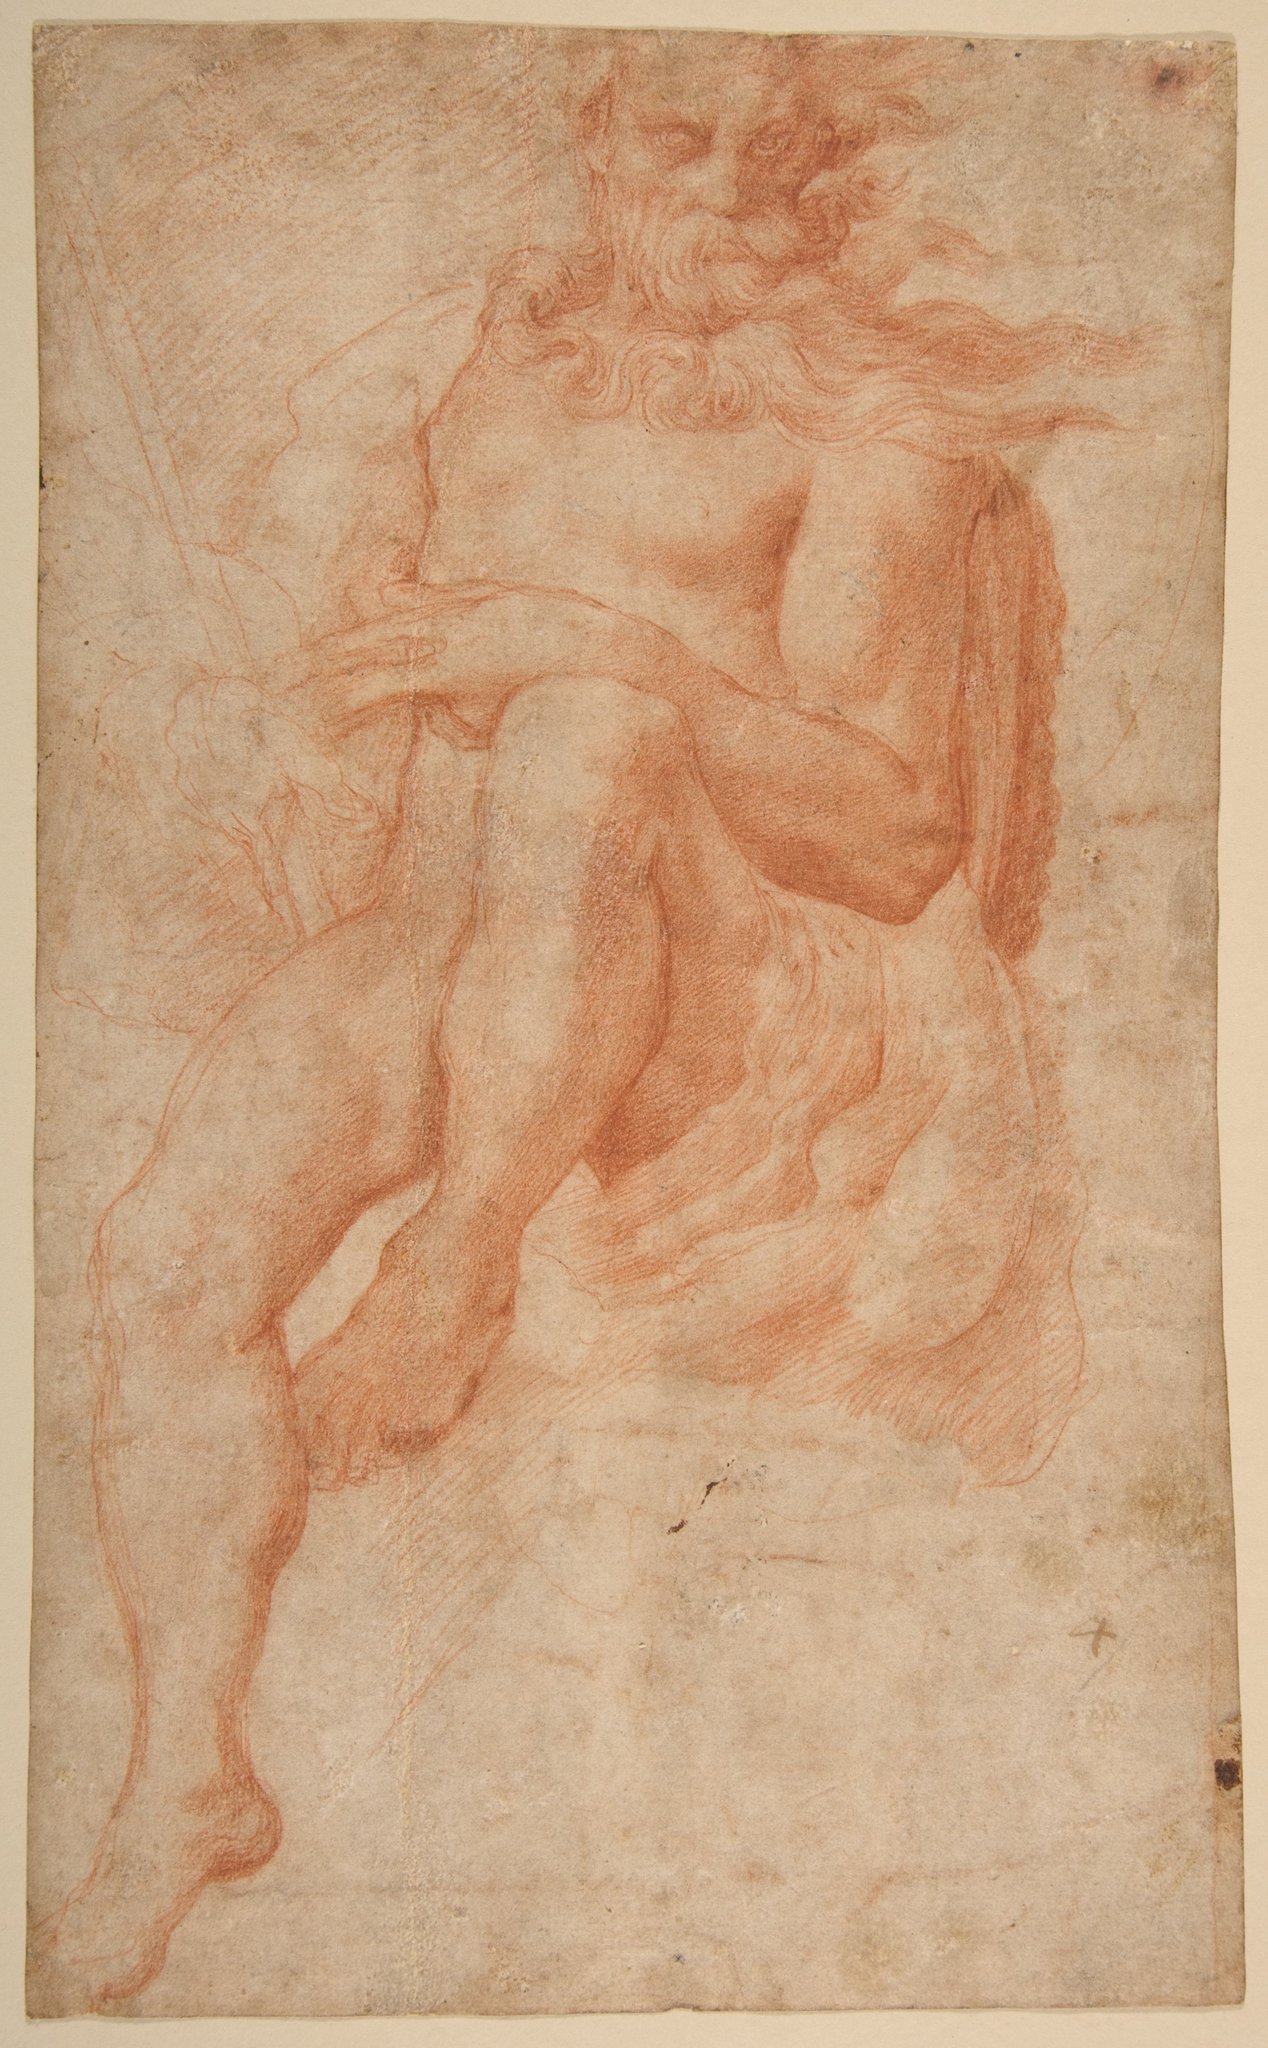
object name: drawing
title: Study for the Figure of Aeolus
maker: pellegrino tibaldi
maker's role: artist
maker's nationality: italian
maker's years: 1527-1596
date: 1549-1551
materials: chalk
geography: italy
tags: men